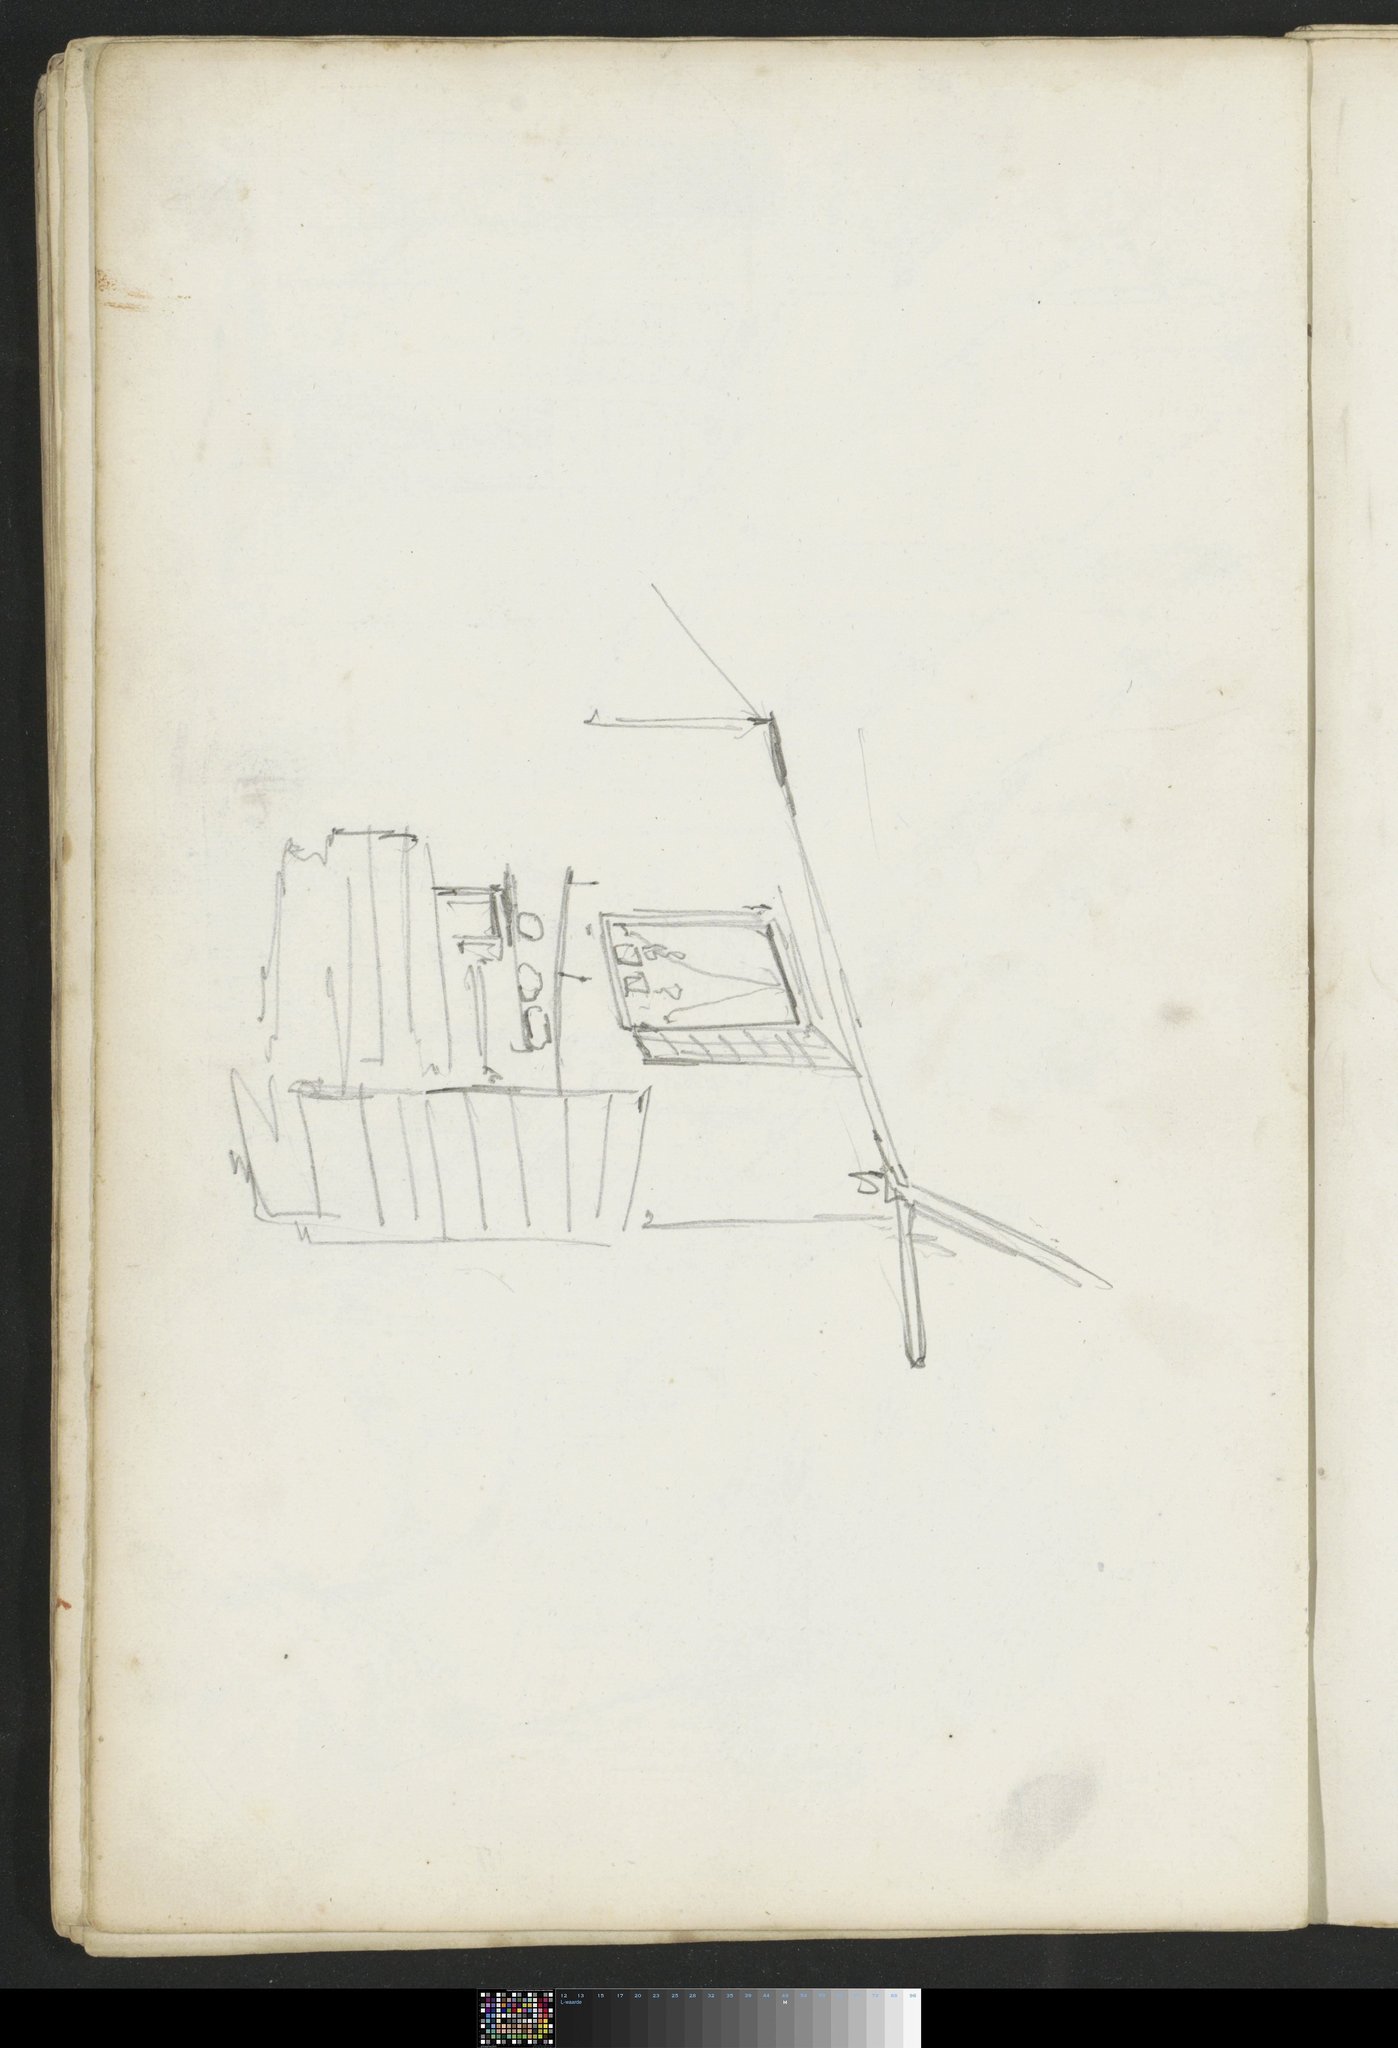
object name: sketchbook leaf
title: Gevel van een huis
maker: willem koekkoek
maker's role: draughtsman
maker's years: 1839-1895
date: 1849-1895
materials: paper, pencil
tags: façade (of house or building)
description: Blad 24 verso uit een schetsboek met 42 bladen.